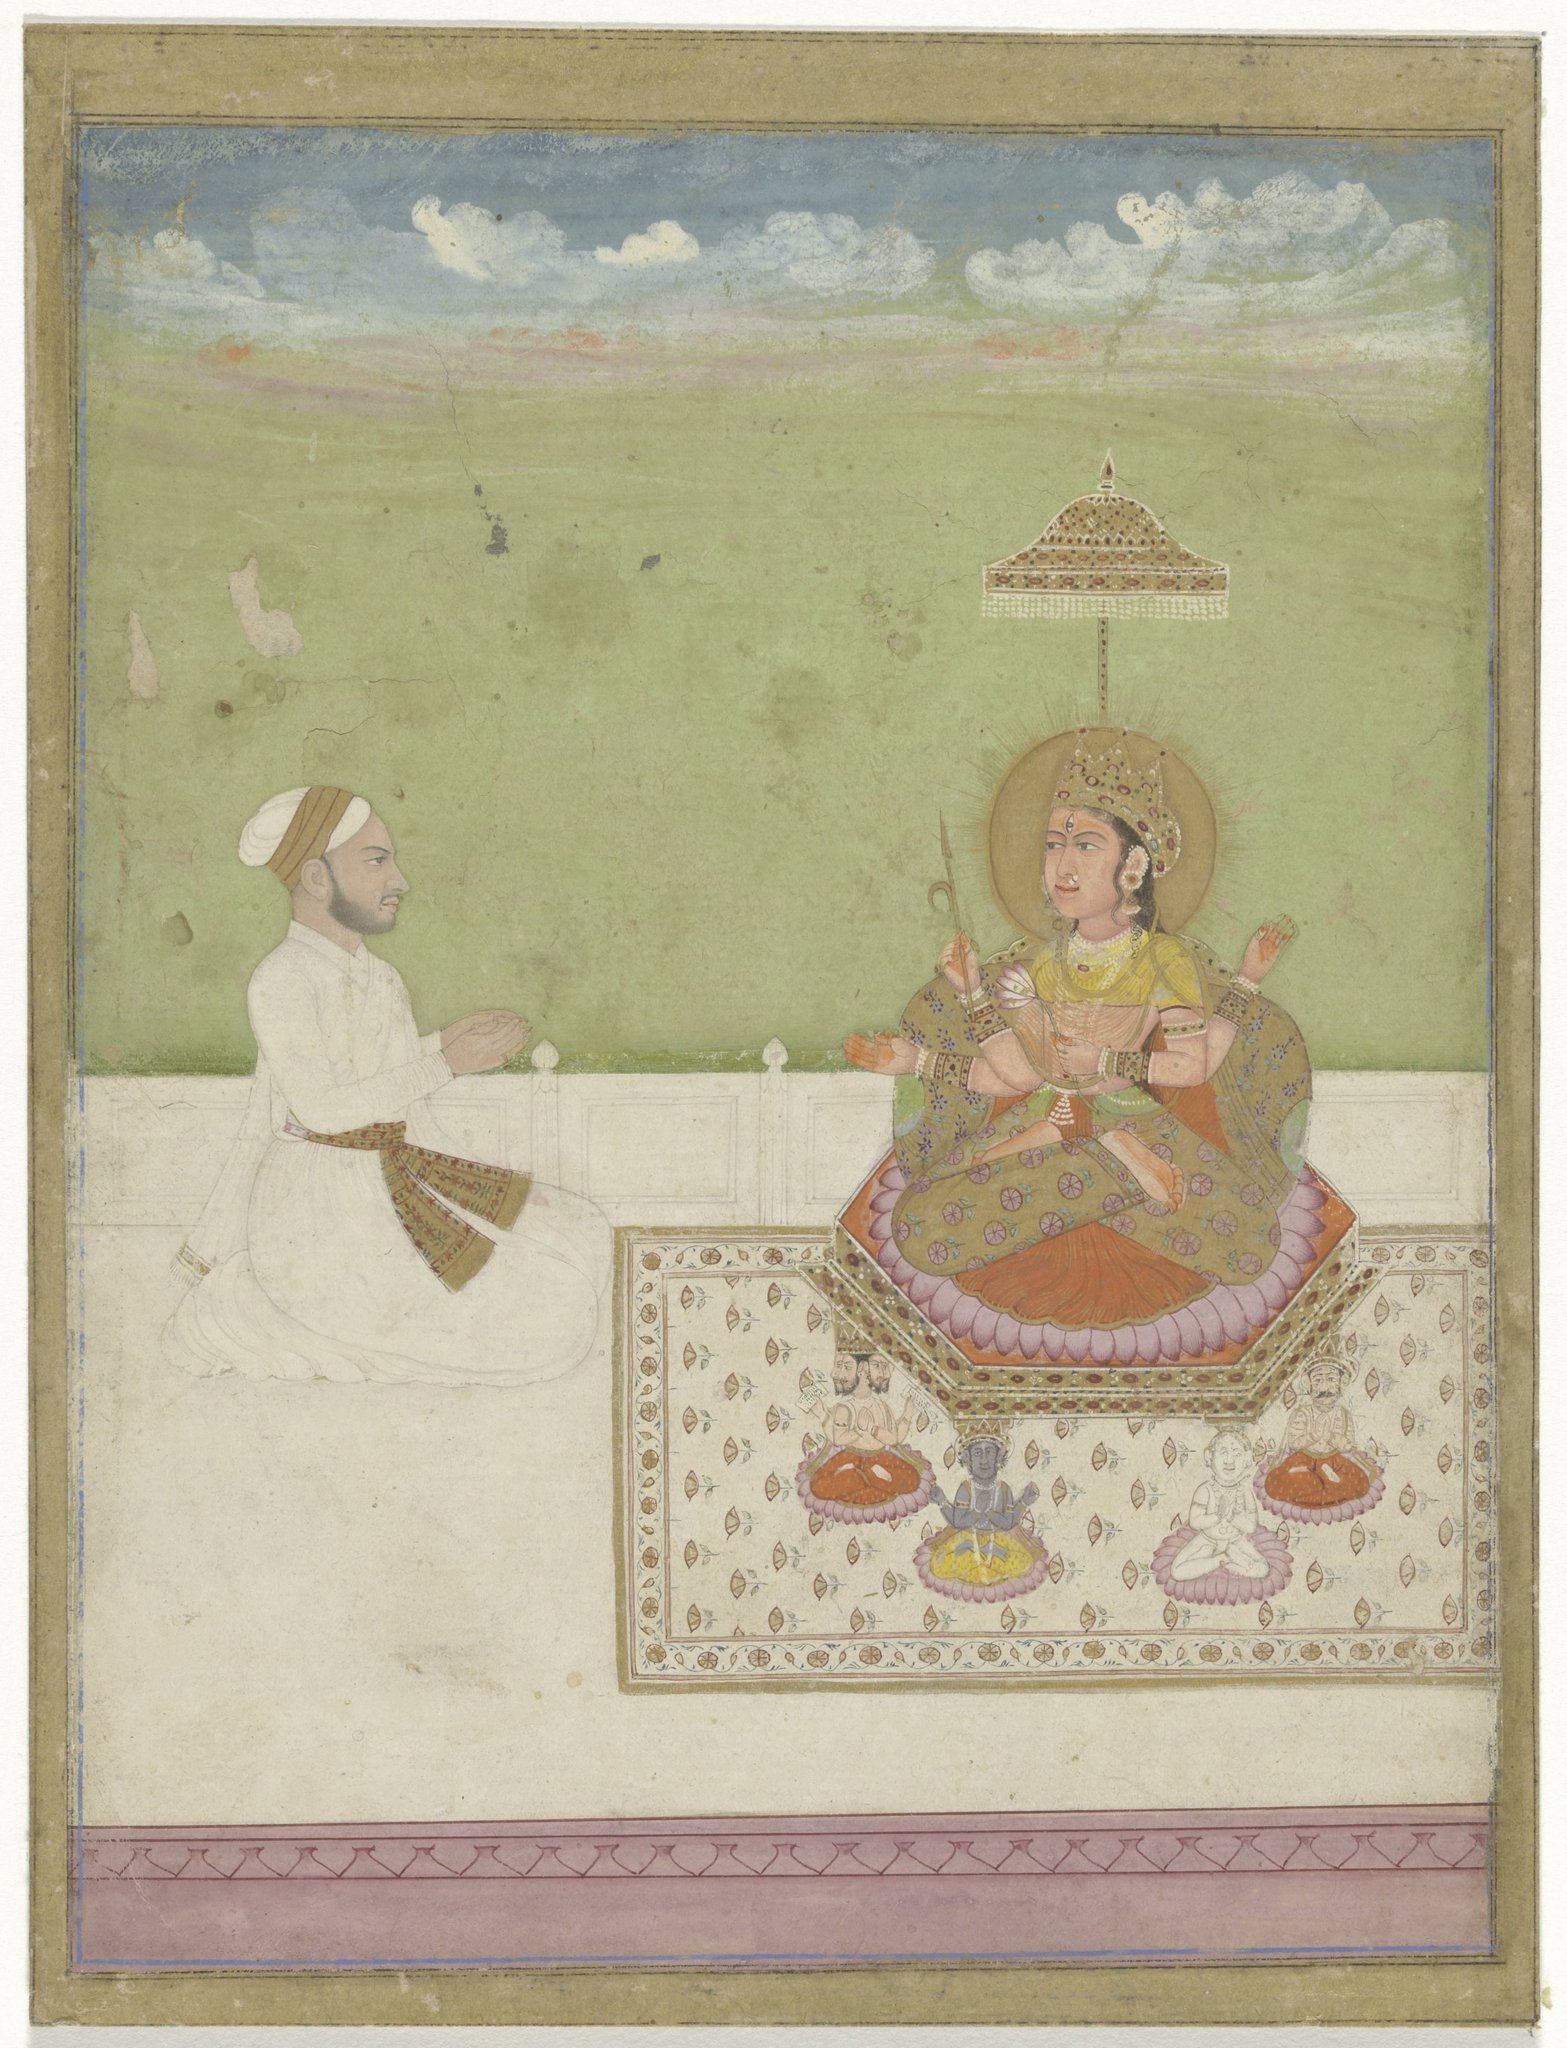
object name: drawing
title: The goddess Tripurasundari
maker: Anonymous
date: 1750-1770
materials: paper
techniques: brush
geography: guler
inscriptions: inscription: ‘.’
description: In Hinduism, goddesses are as important as the male deities. For some, the Great Goddess, who has many names and takes different forms, is the ultimate reality in the universe, the creator and queen of the cosmos. One of these forms is Tripurasundari. She sits on a throne, towering above four important male deities: Brahma, Vishnu, Shiva and Indra, whose much smaller figures form the legs of the throne.